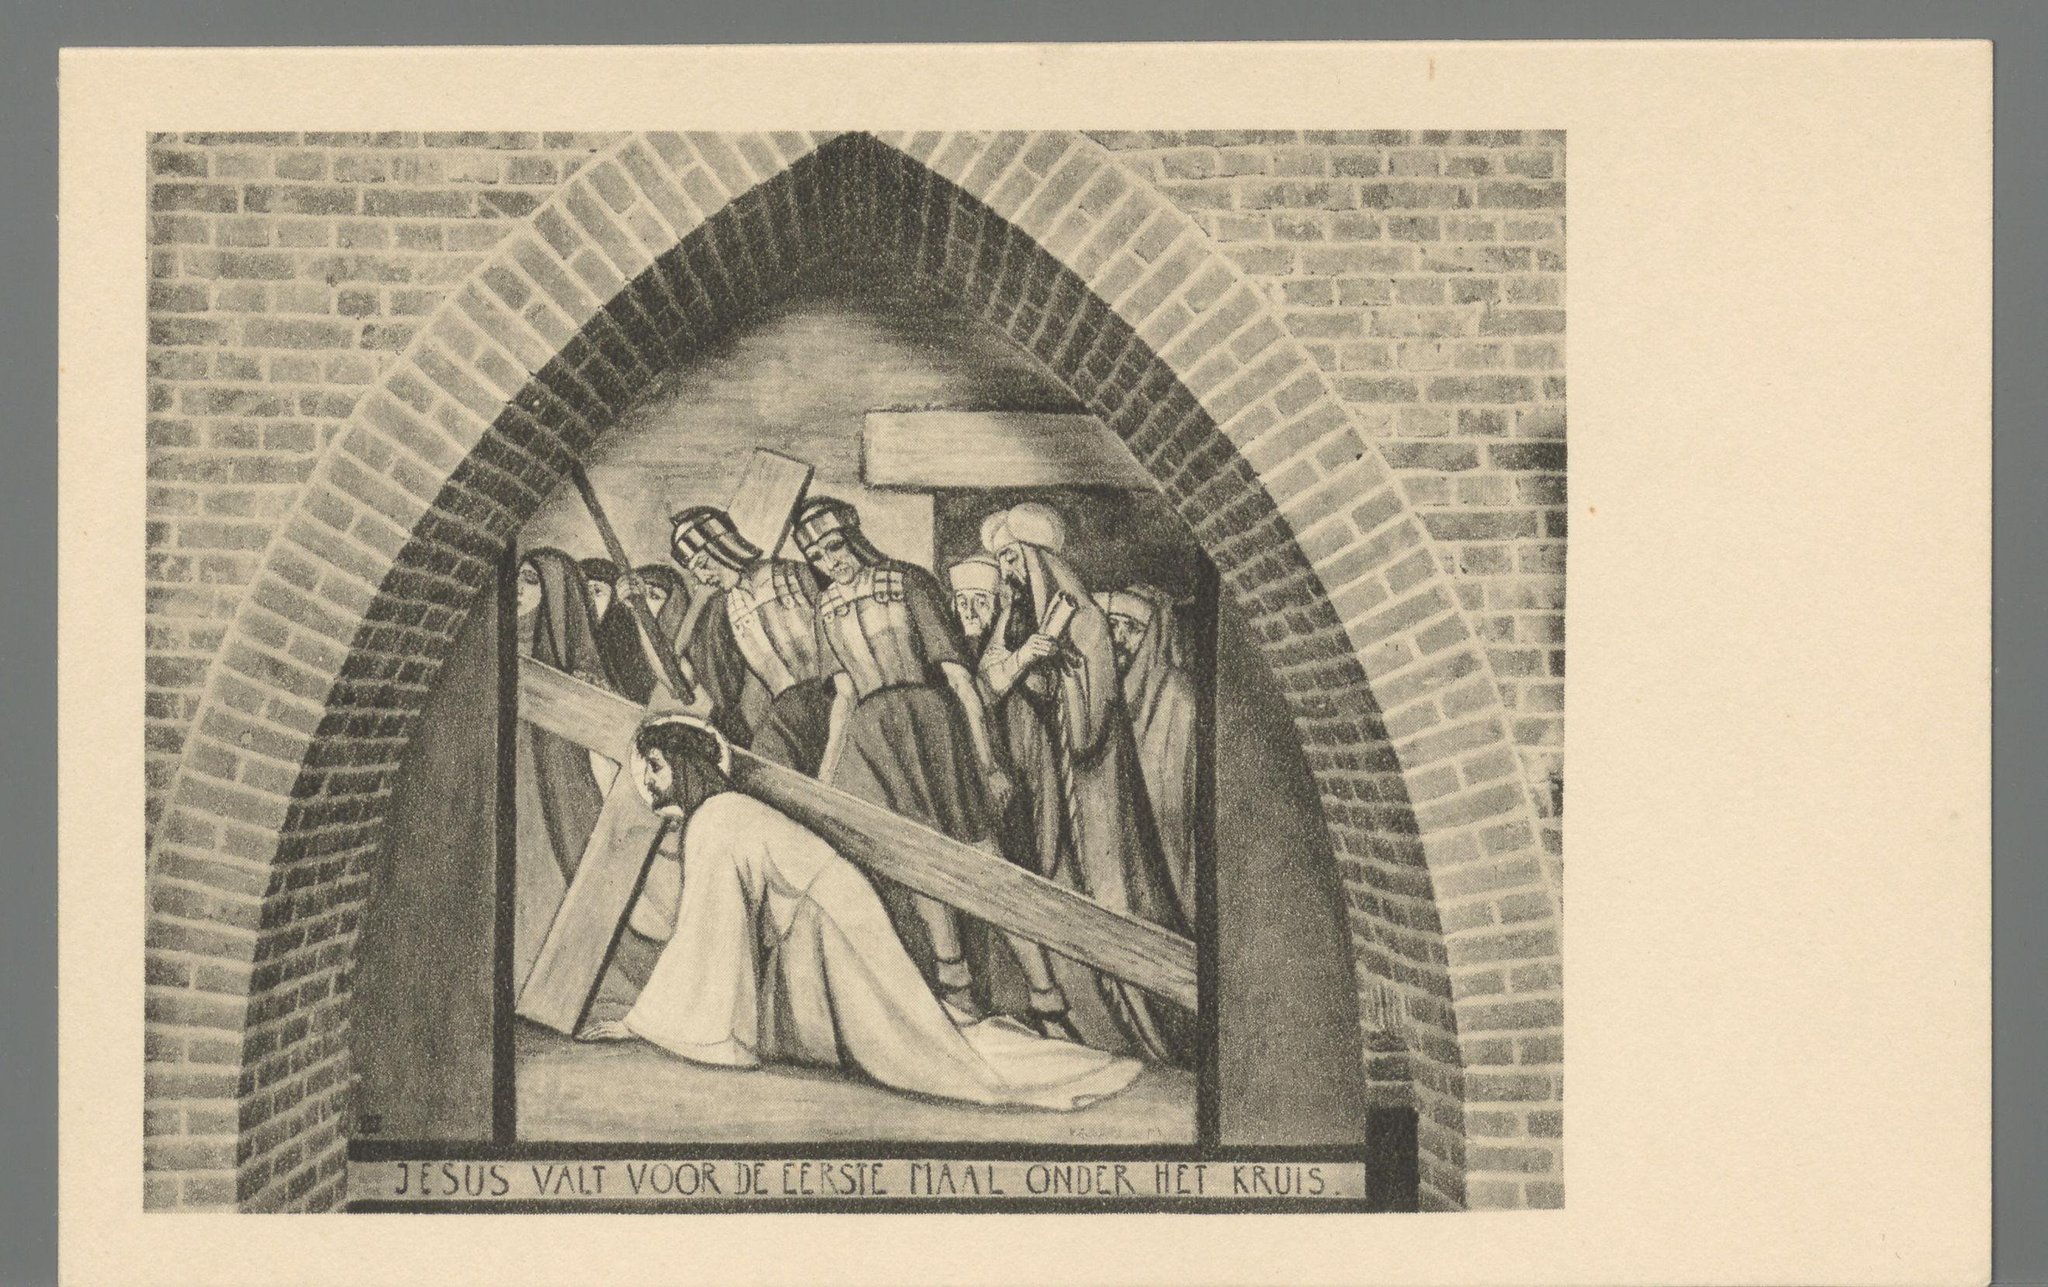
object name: ansichtkaart, prentbriefkaart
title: Jesus valt voor de eerste maal onder het kruis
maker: Anonymous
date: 1929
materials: cardboard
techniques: rotogravure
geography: amsterdam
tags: stations of the cross, interior of church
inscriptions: collector's mark: ‘AFE v S’